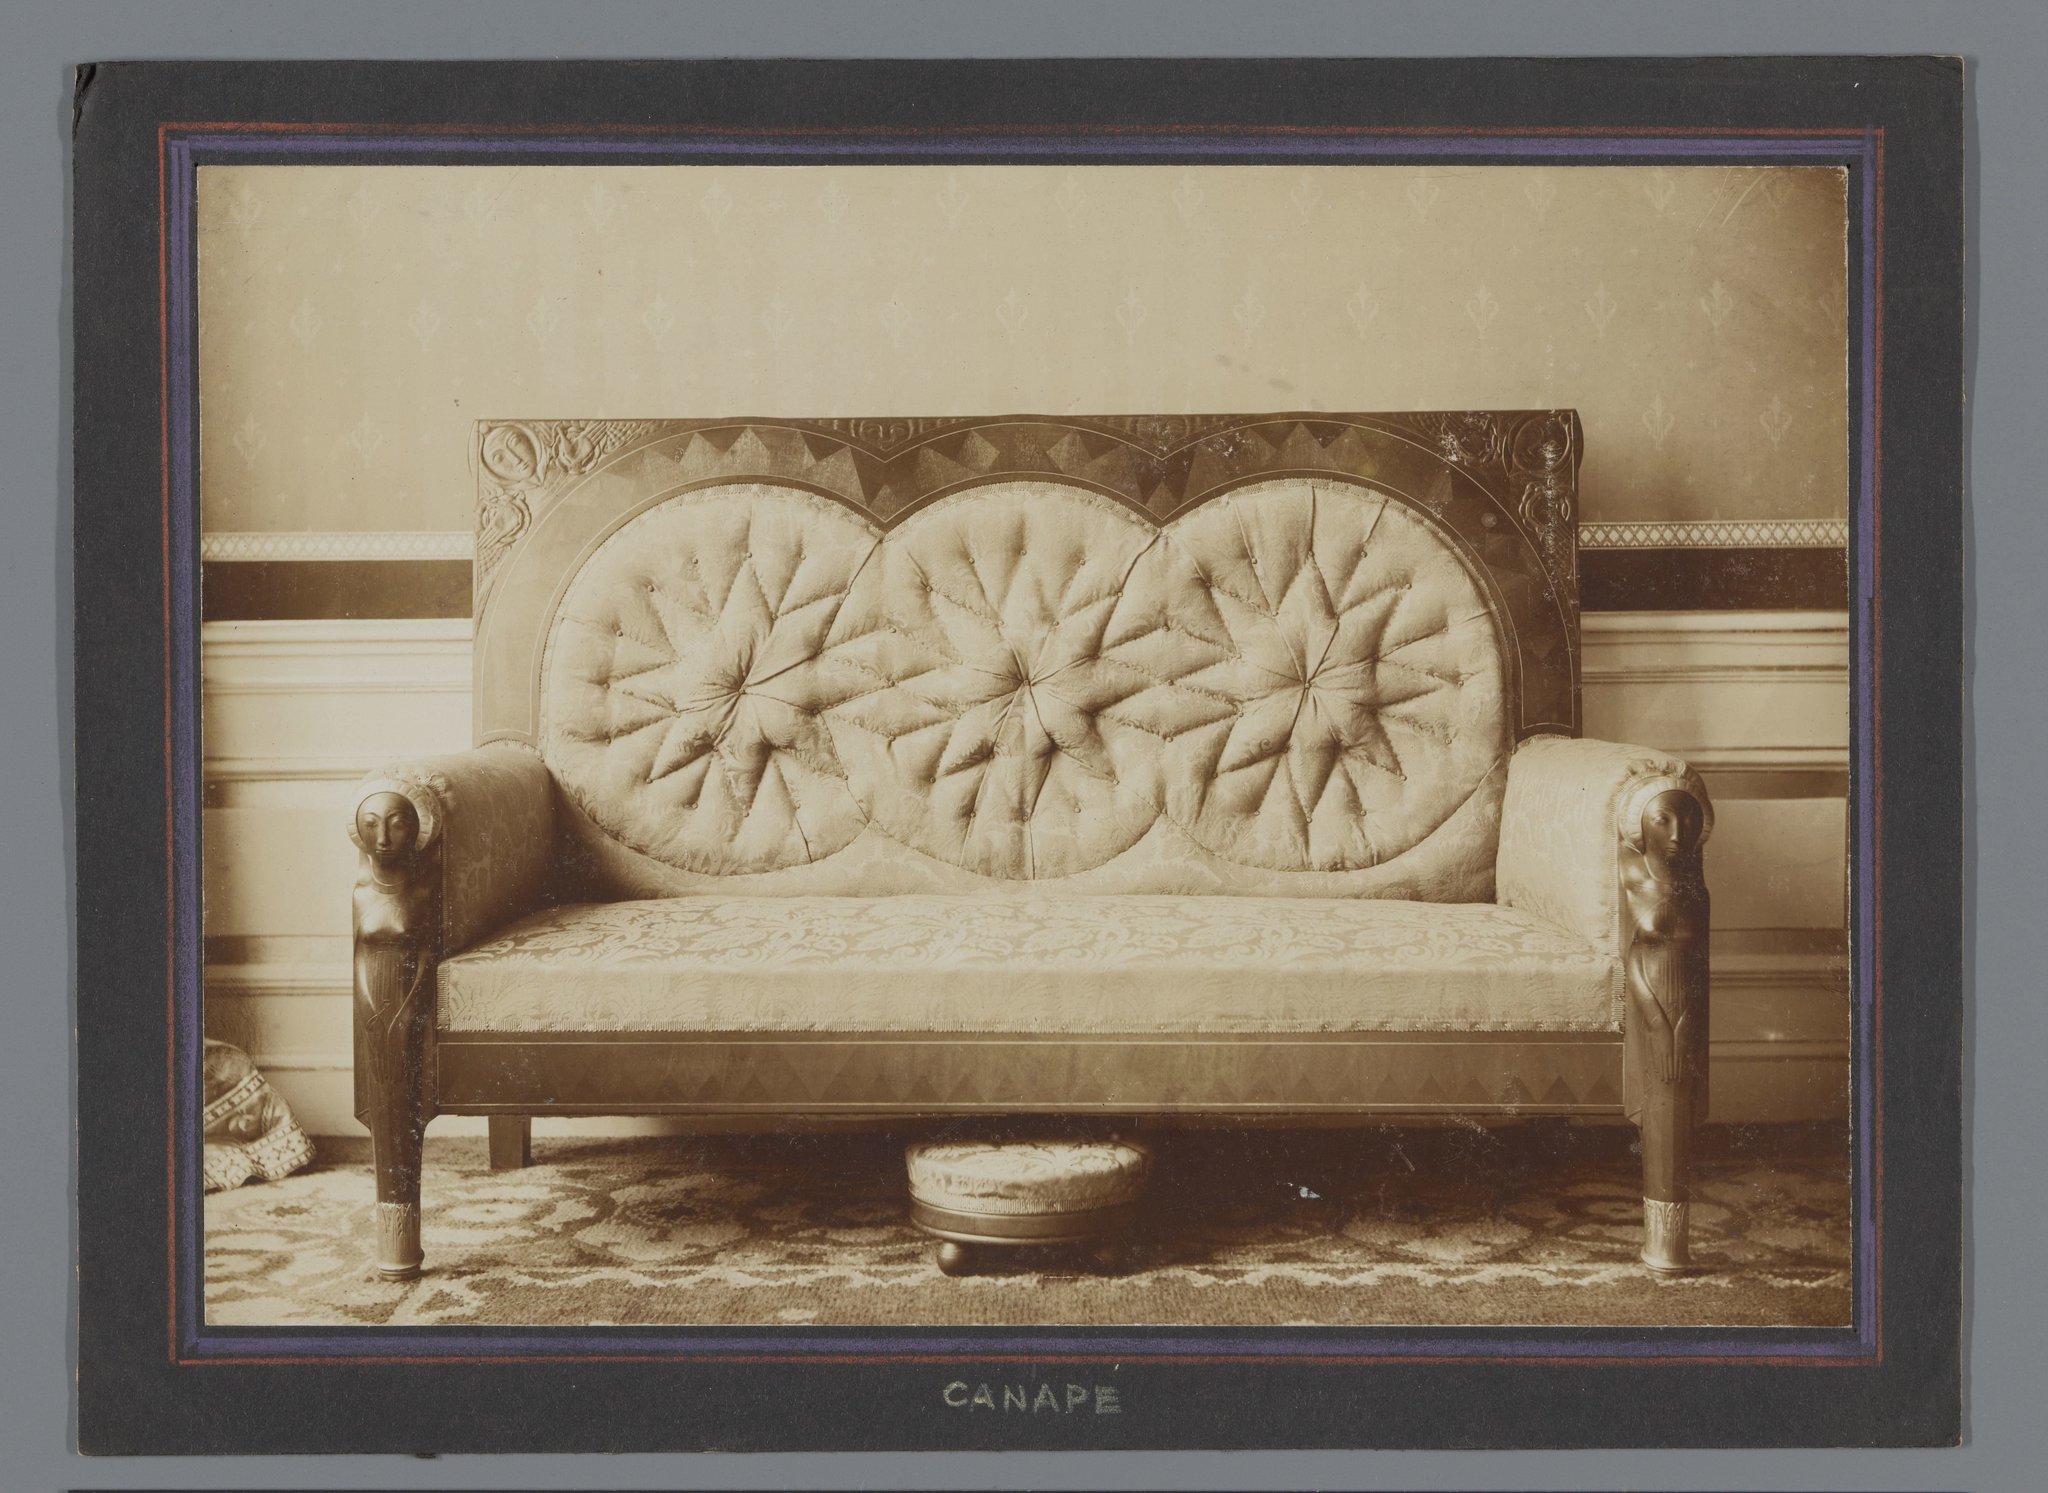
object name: photograph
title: Bank naar ontwerp van Mathieu Lauweriks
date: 1910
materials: cardboard, photographic support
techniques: collodion silver print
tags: bench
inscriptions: annotation: ‘JM Lauweriks/ Ma[...]ts 18, Düsseldorf/ Canapé’, annotation: ‘CANAPÉ’, inscription: ‘salon-ameublement uitgevoerd in cuba-mahoni-/ hout met verguld en geciseleerd koperwerk,/ voor den heer J. P. W. Schuurman, Den Haag./ Ontworpen door J. L. M. Lauweriks, architect./ Uitgevoerd door de firma Wed. C. Nederkoorn,/ meubelmaker te Haarlem. + Beelhouwwerk/ van M. J. Hack te Amsterdam. + Koperwerk van/ F. Zwollo, Amsterdam +++++++++’